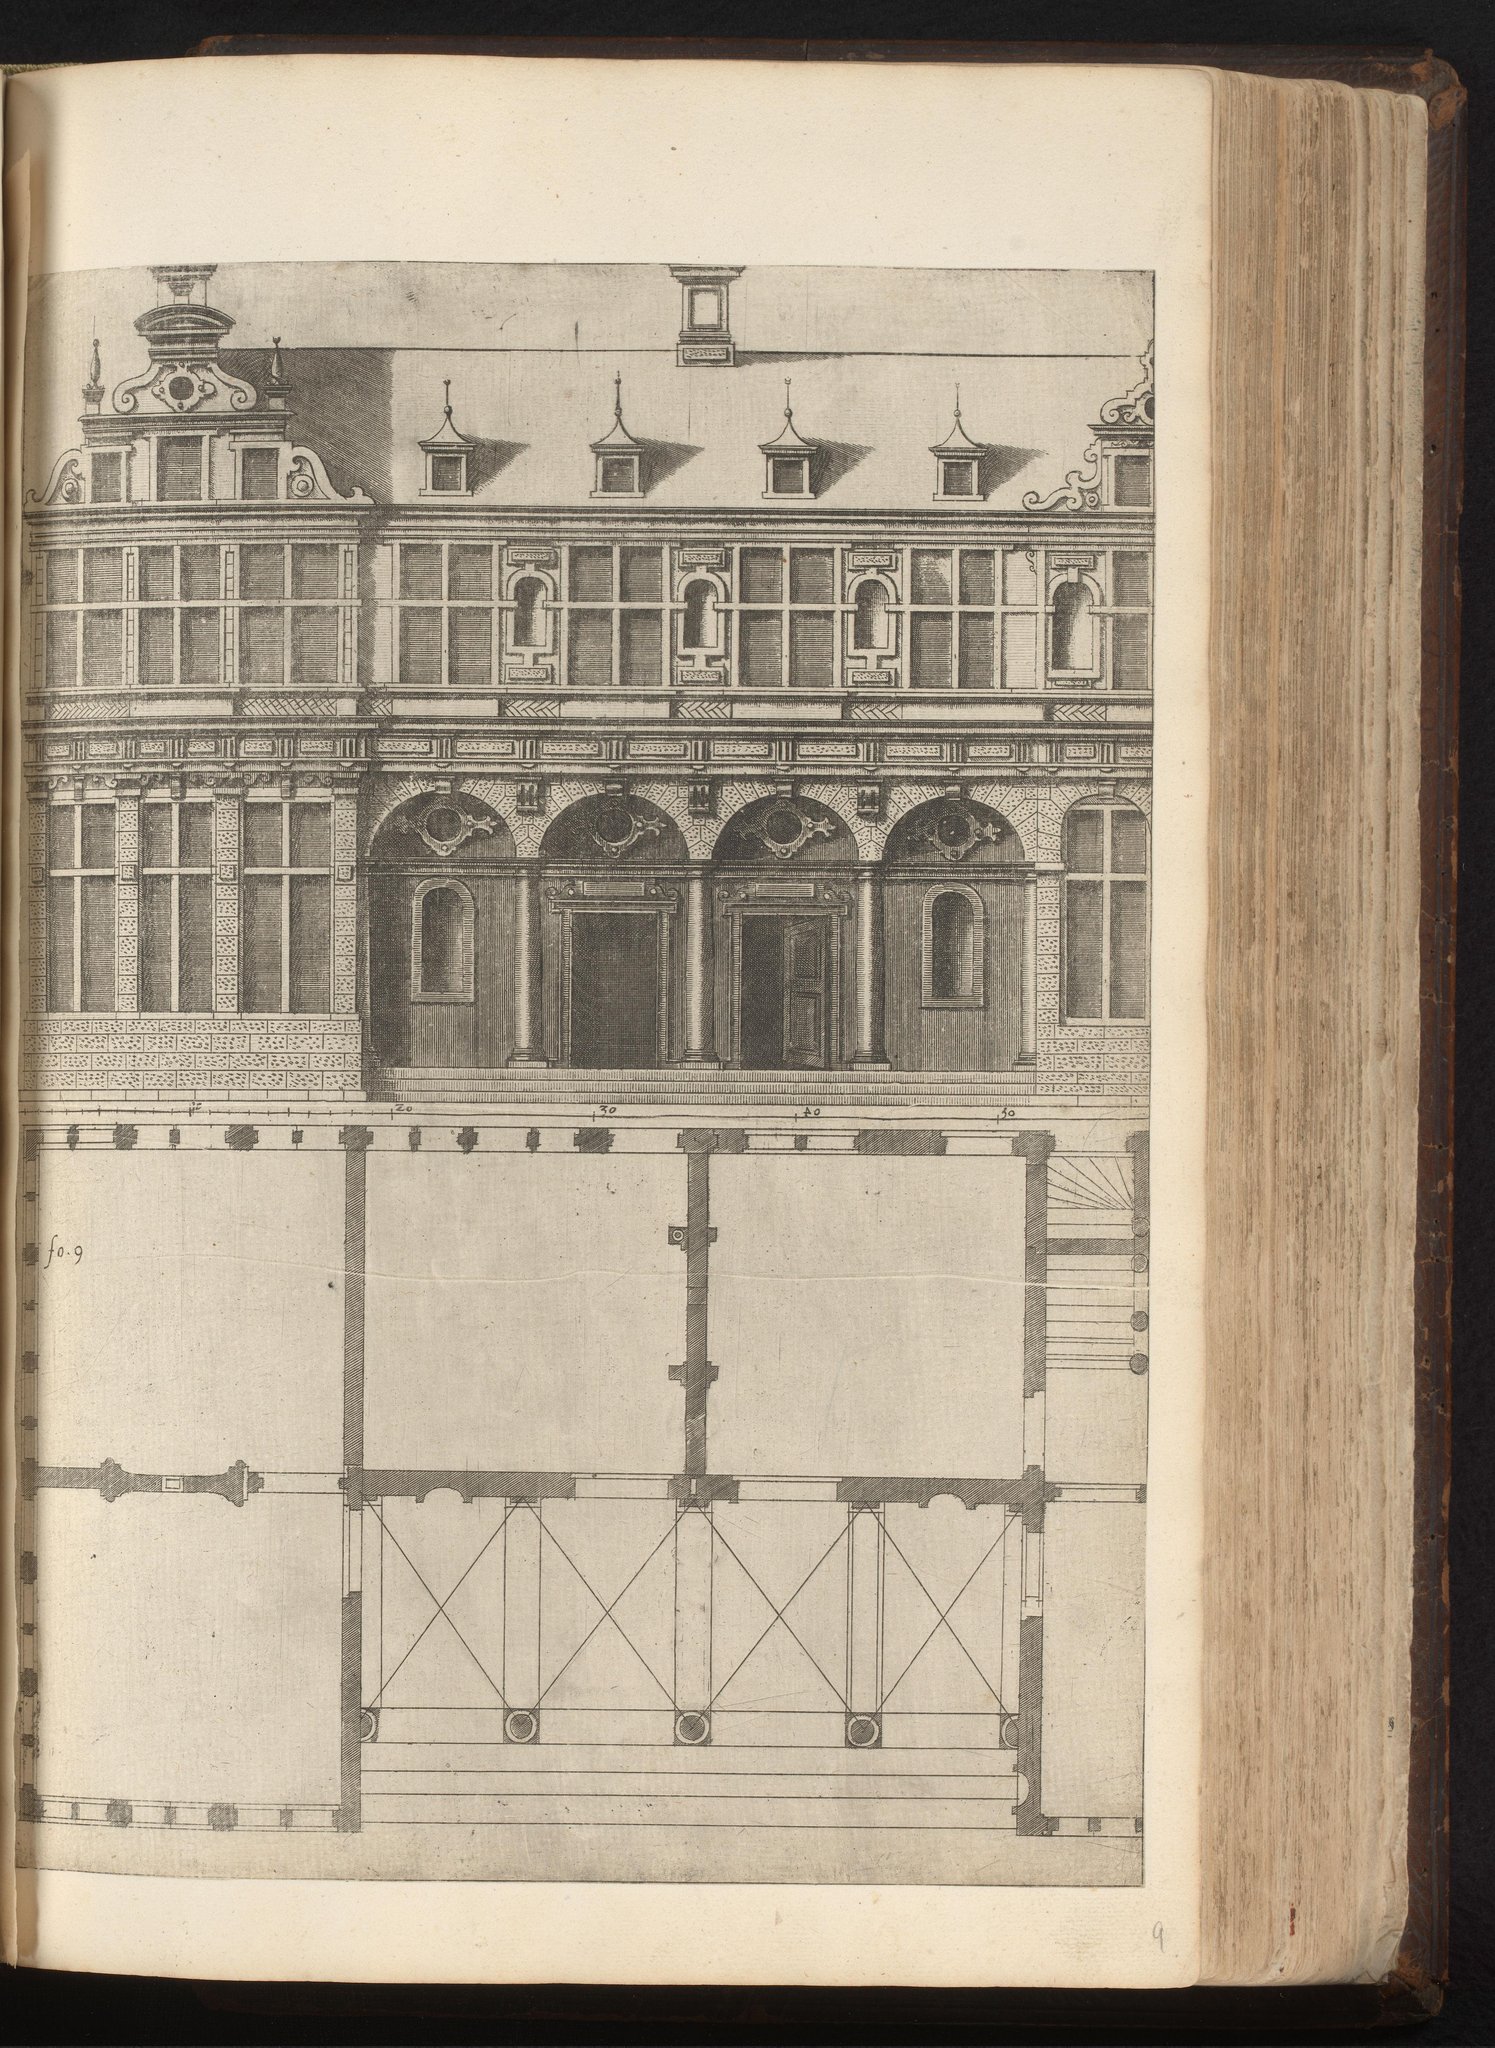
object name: album leaf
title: Plattegrond en gevel in de Dorische orde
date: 1581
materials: paper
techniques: engraving, etching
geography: antwerp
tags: doric order ~ architecture, civic architecture; edifices; dwellings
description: Prent uit: Vredeman de Vries, Hans. Architectura oder Bauung der Antiquen auss dem Vitruvius, waellches sein funff Collummen orden, (...). Antwerpen: Gerard de Jode en Gerard Smits, 1581. Prent eerder verschenen in de 1577-editie.